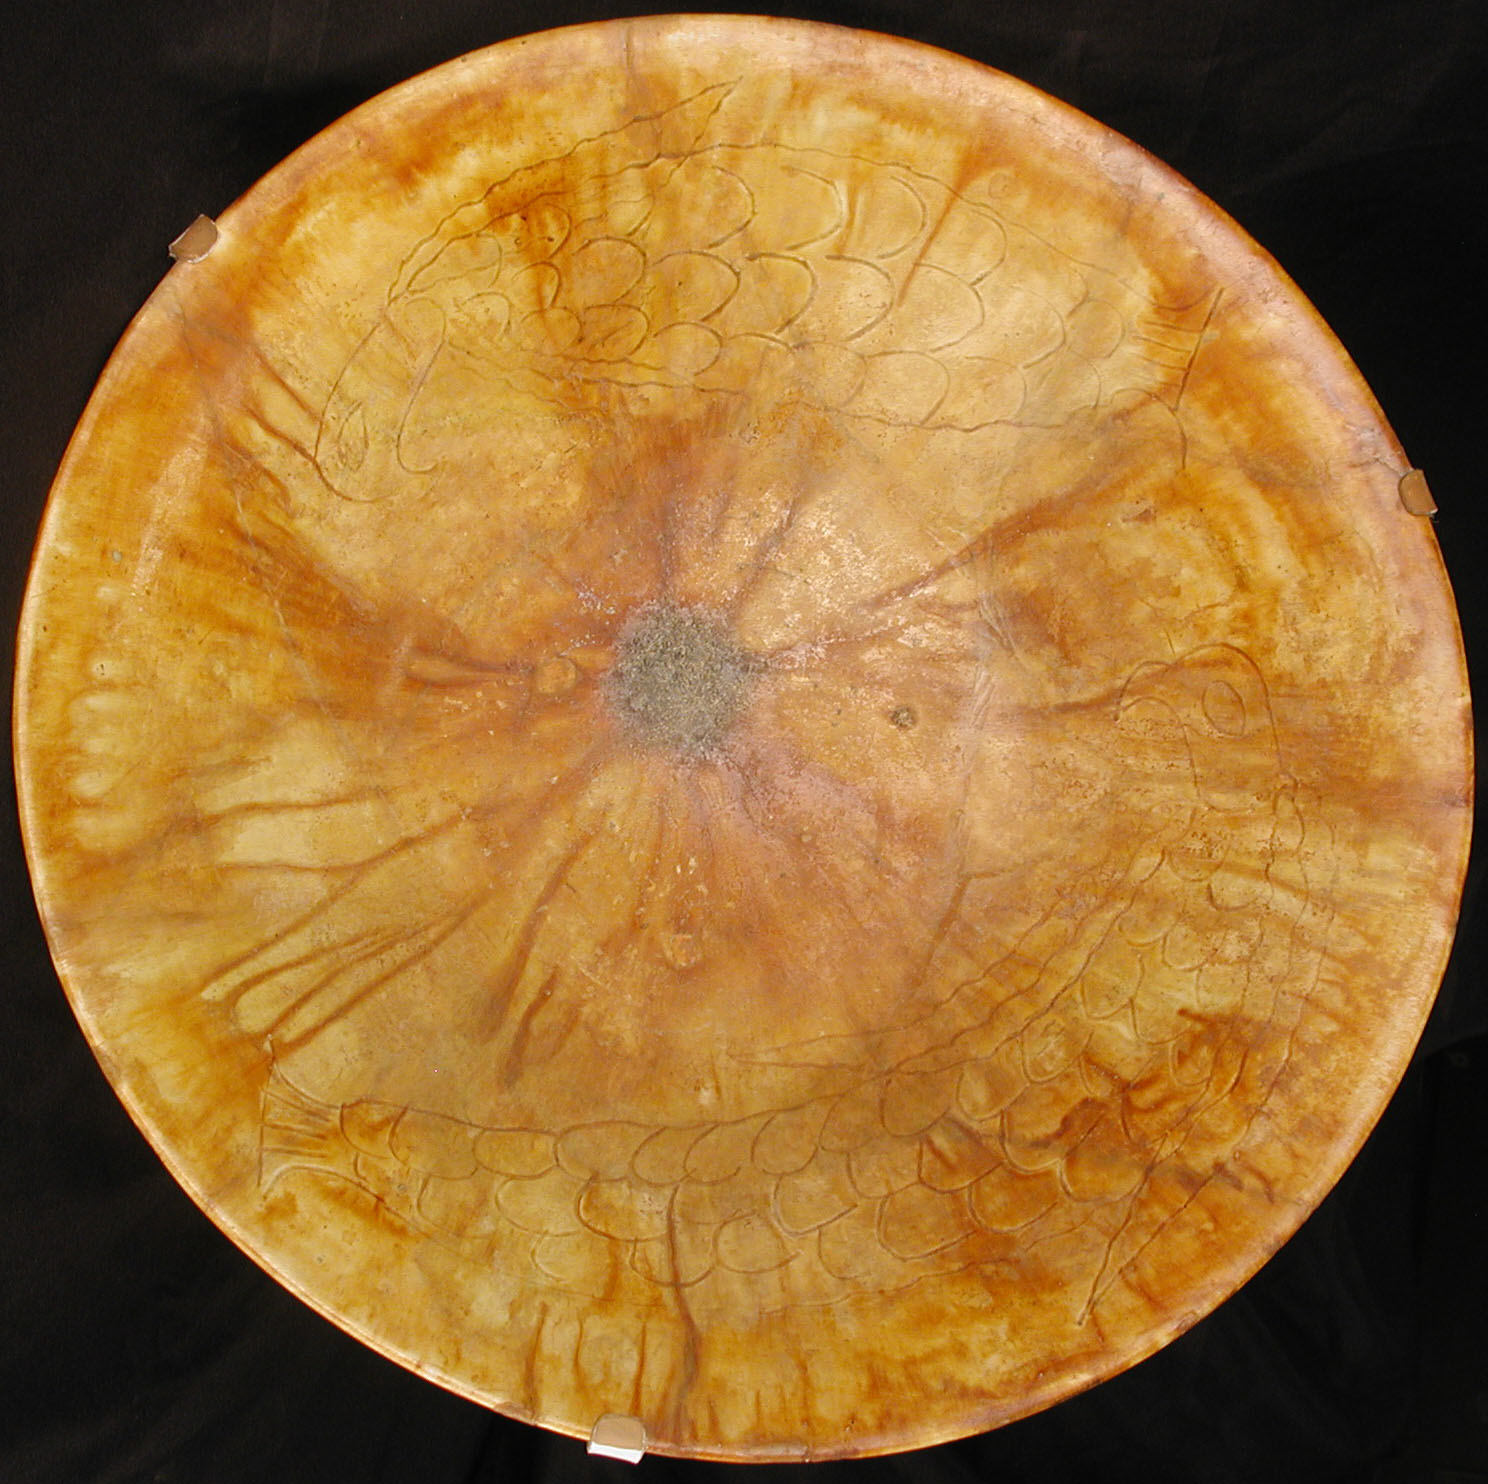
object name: bowl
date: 767-833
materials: earthenware, glaze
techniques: incising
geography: iran